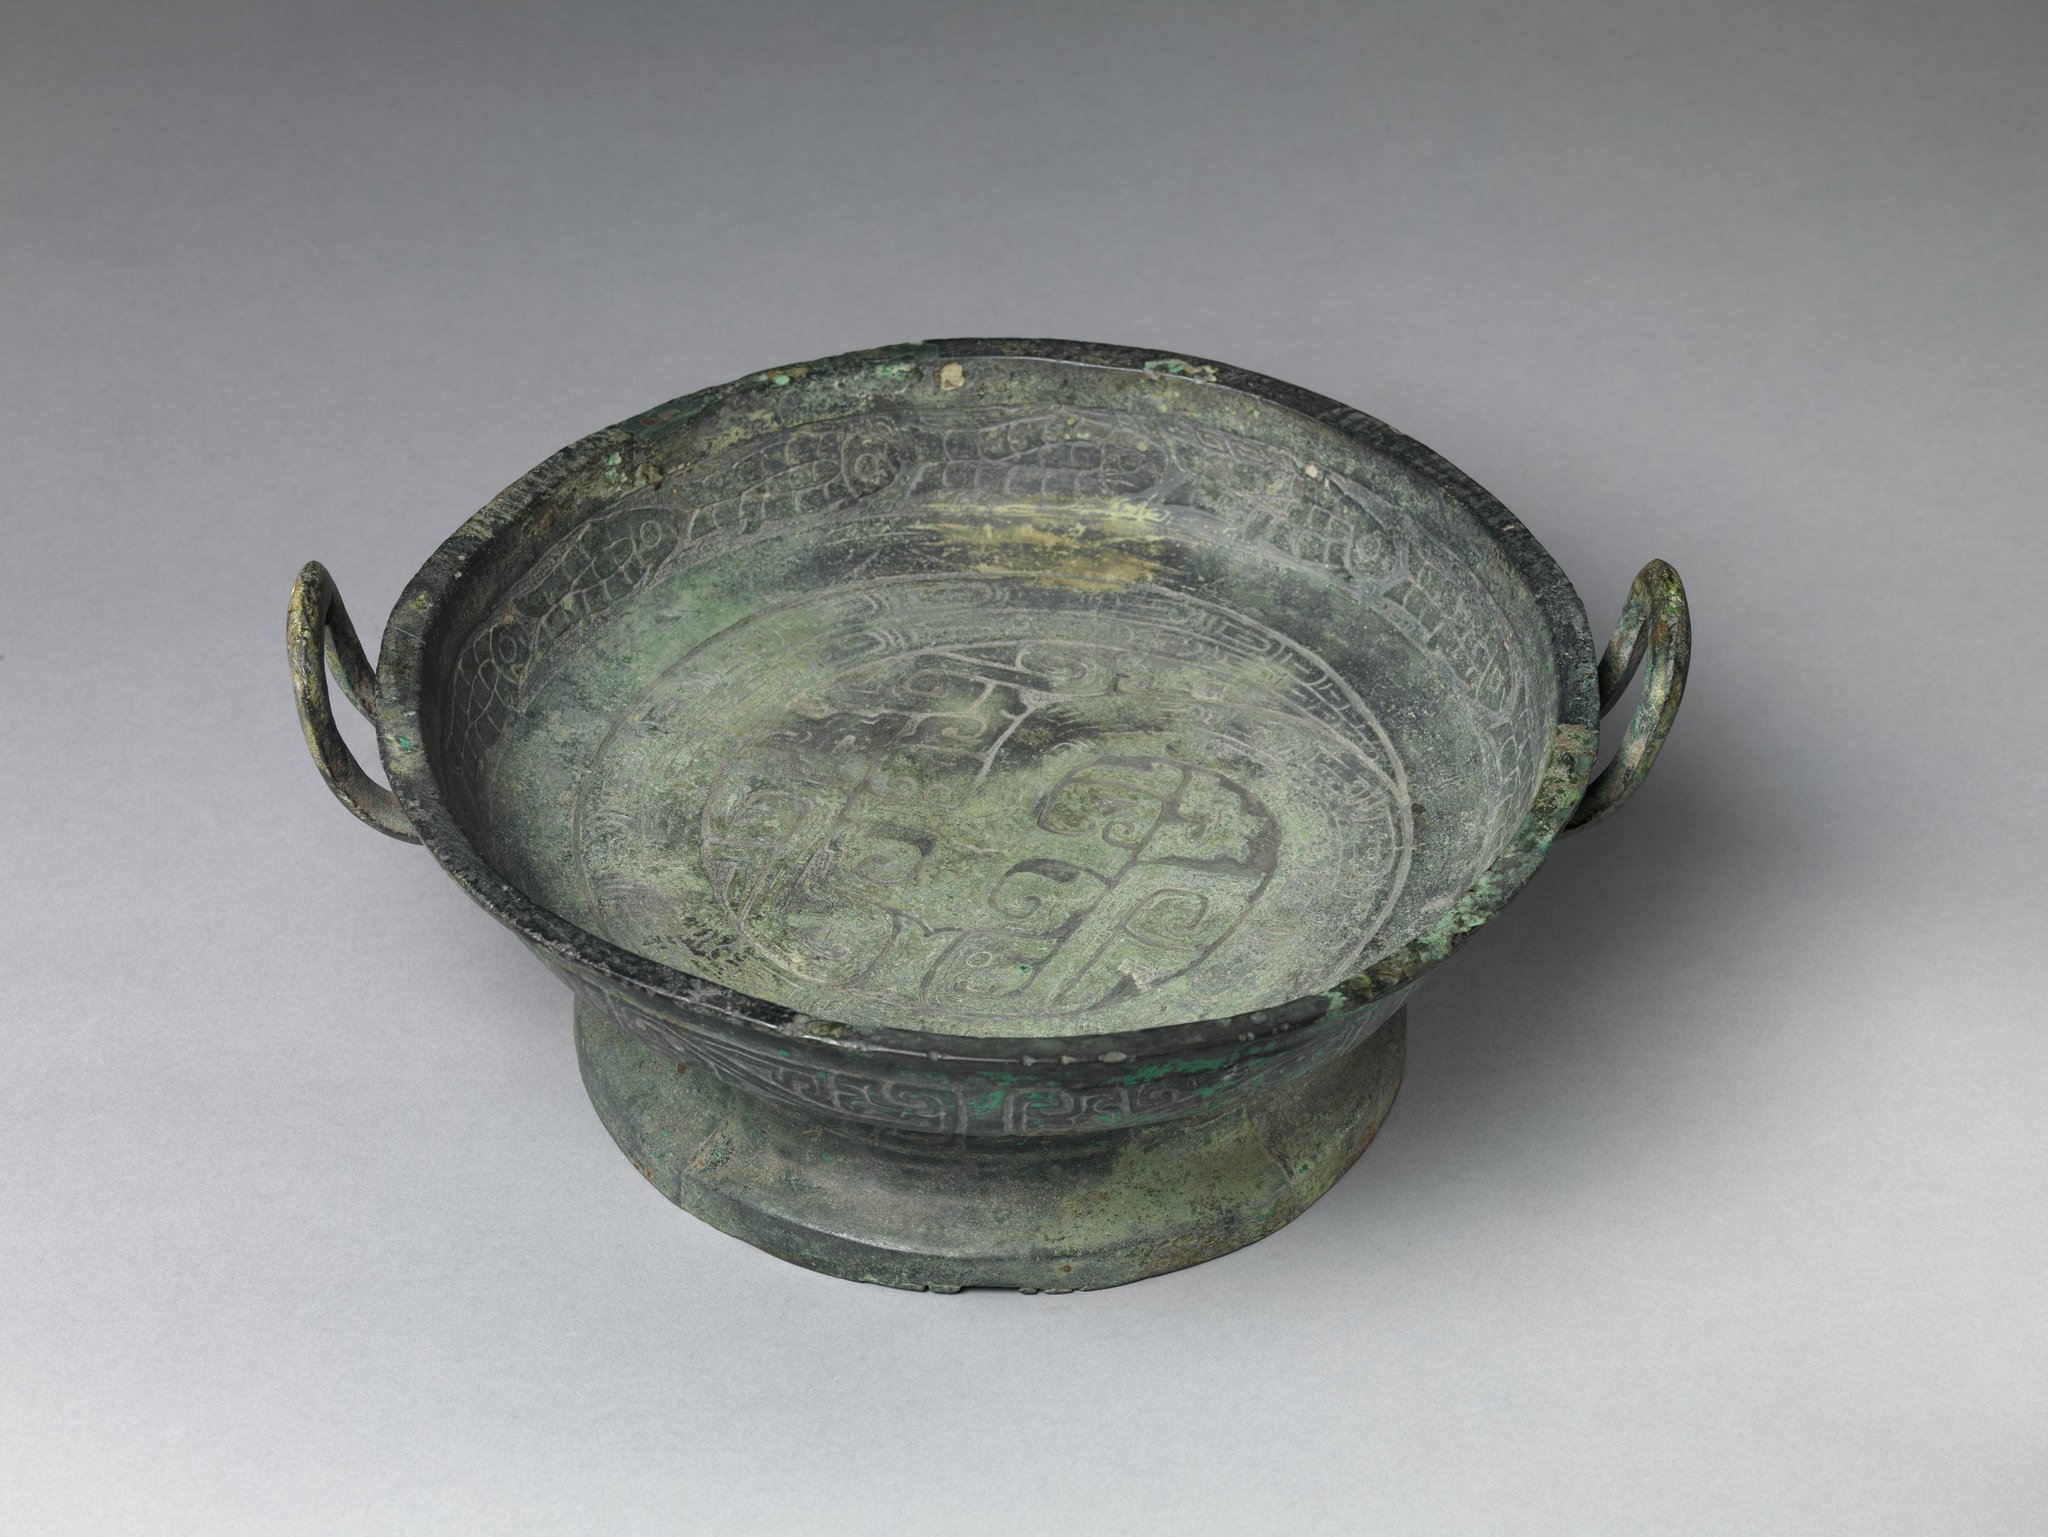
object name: basin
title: Water basin (Pan)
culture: chinese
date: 800-601 BCE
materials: bronze